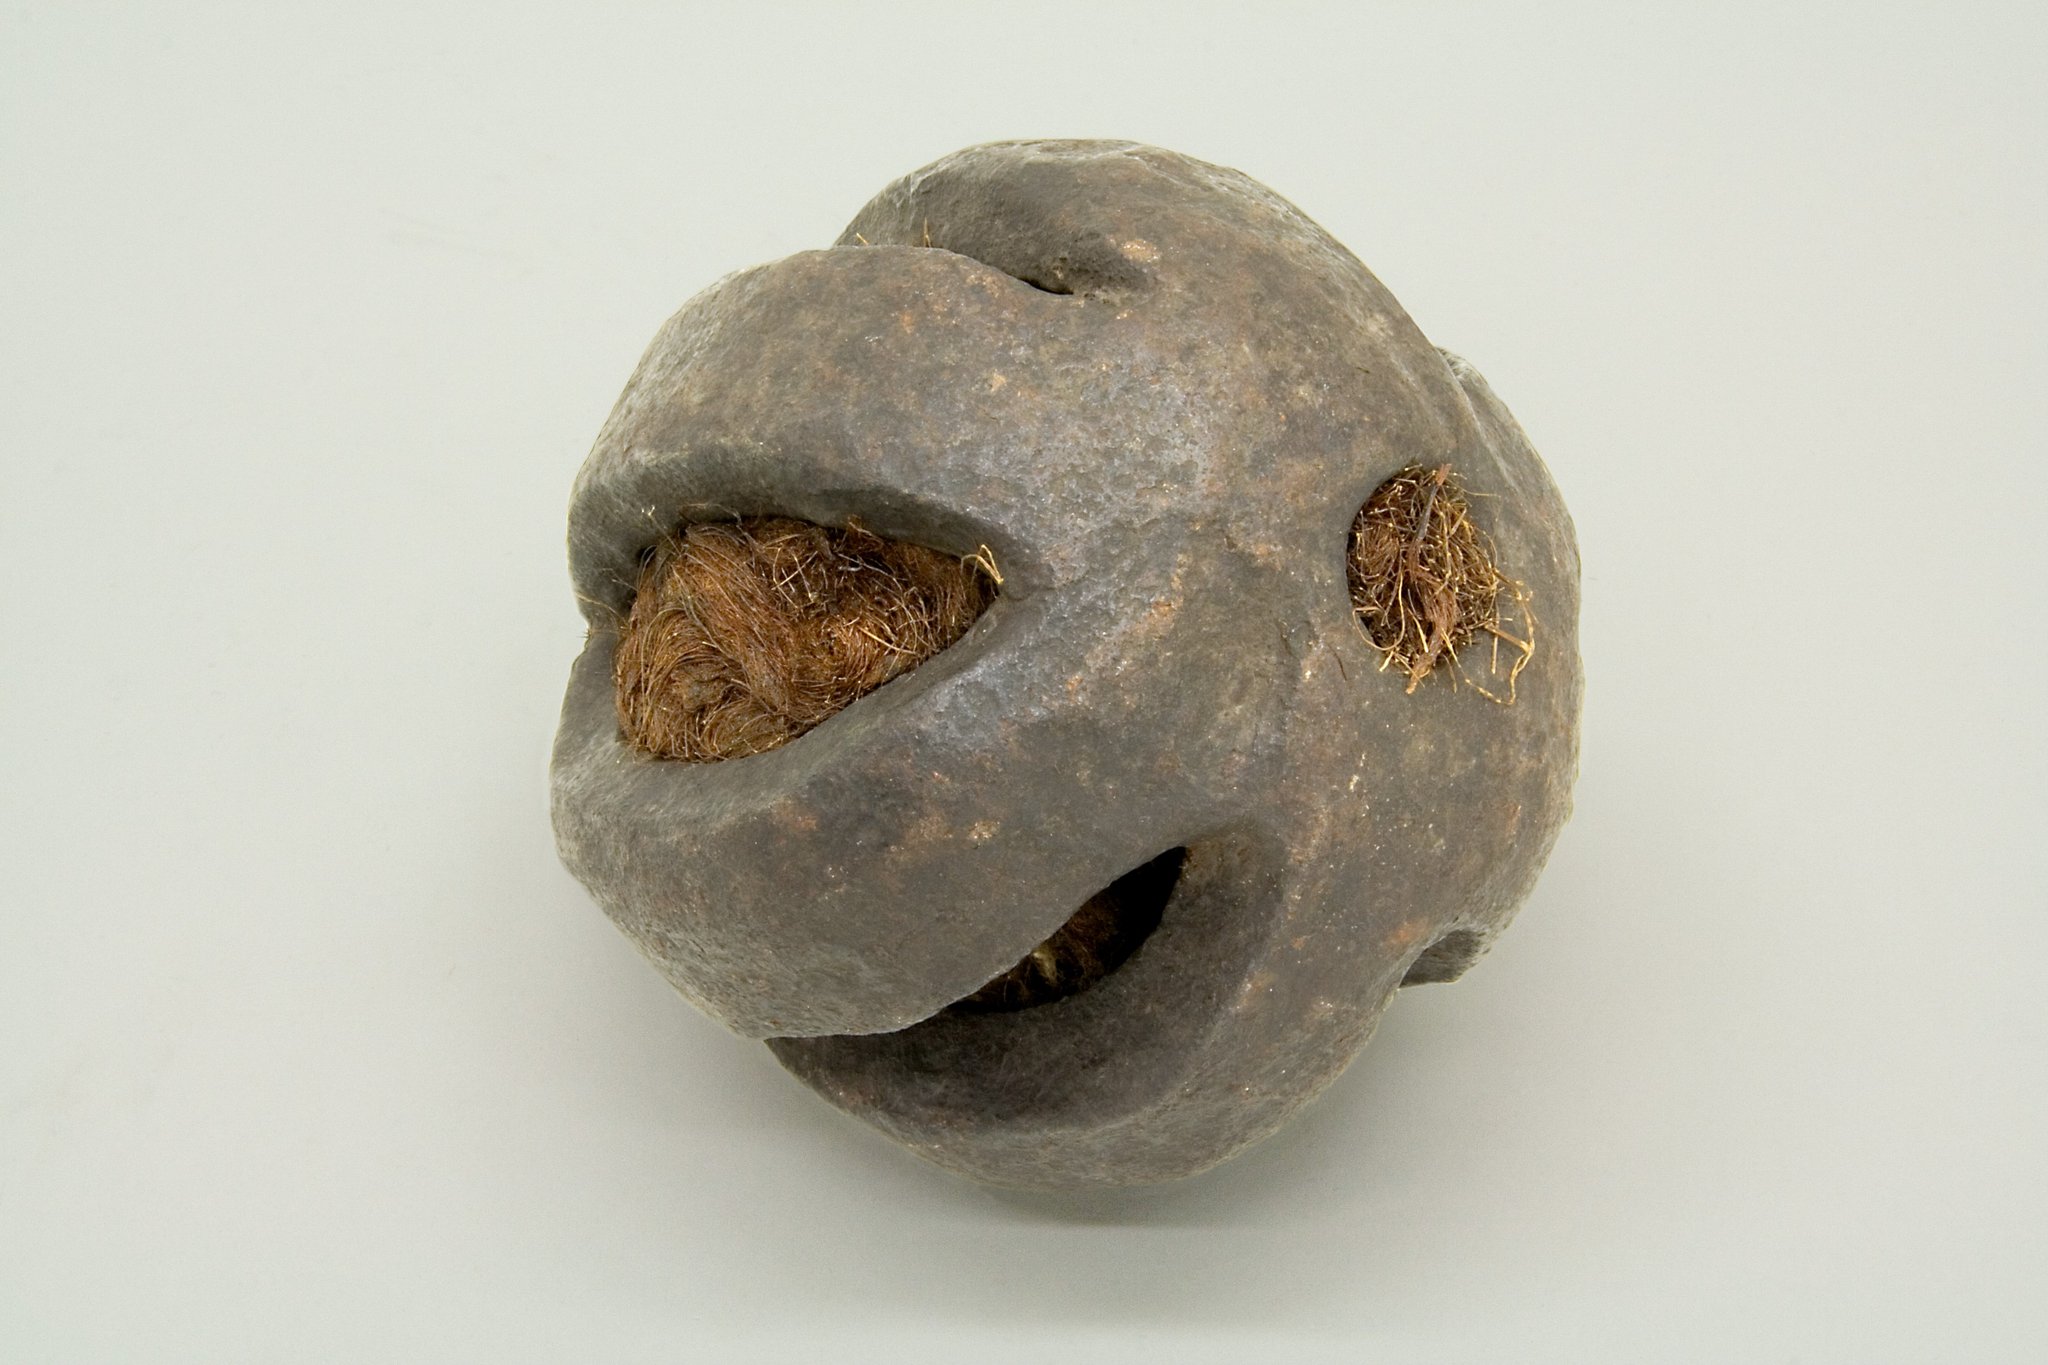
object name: cannonball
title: Cannon Ball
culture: french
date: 1367-1400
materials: iron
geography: france